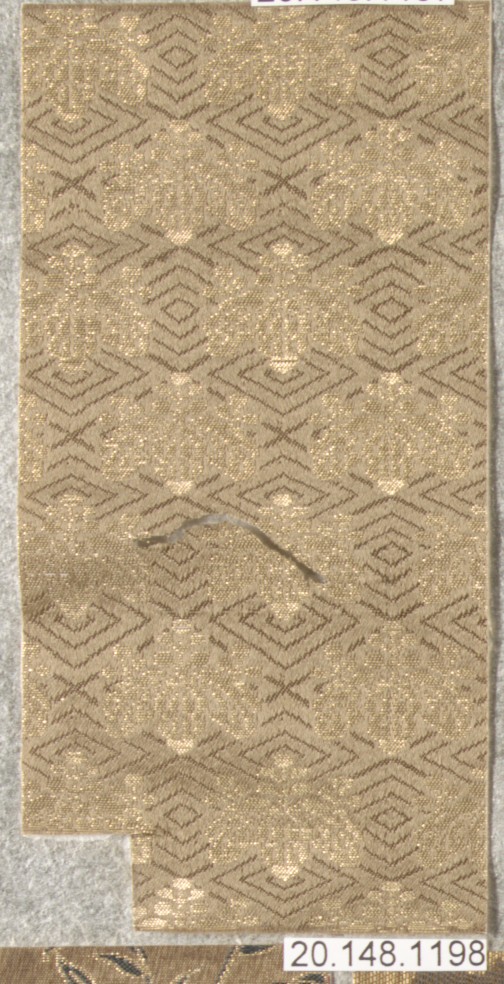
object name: piece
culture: japanese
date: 1701-1800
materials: silk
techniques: compound weave